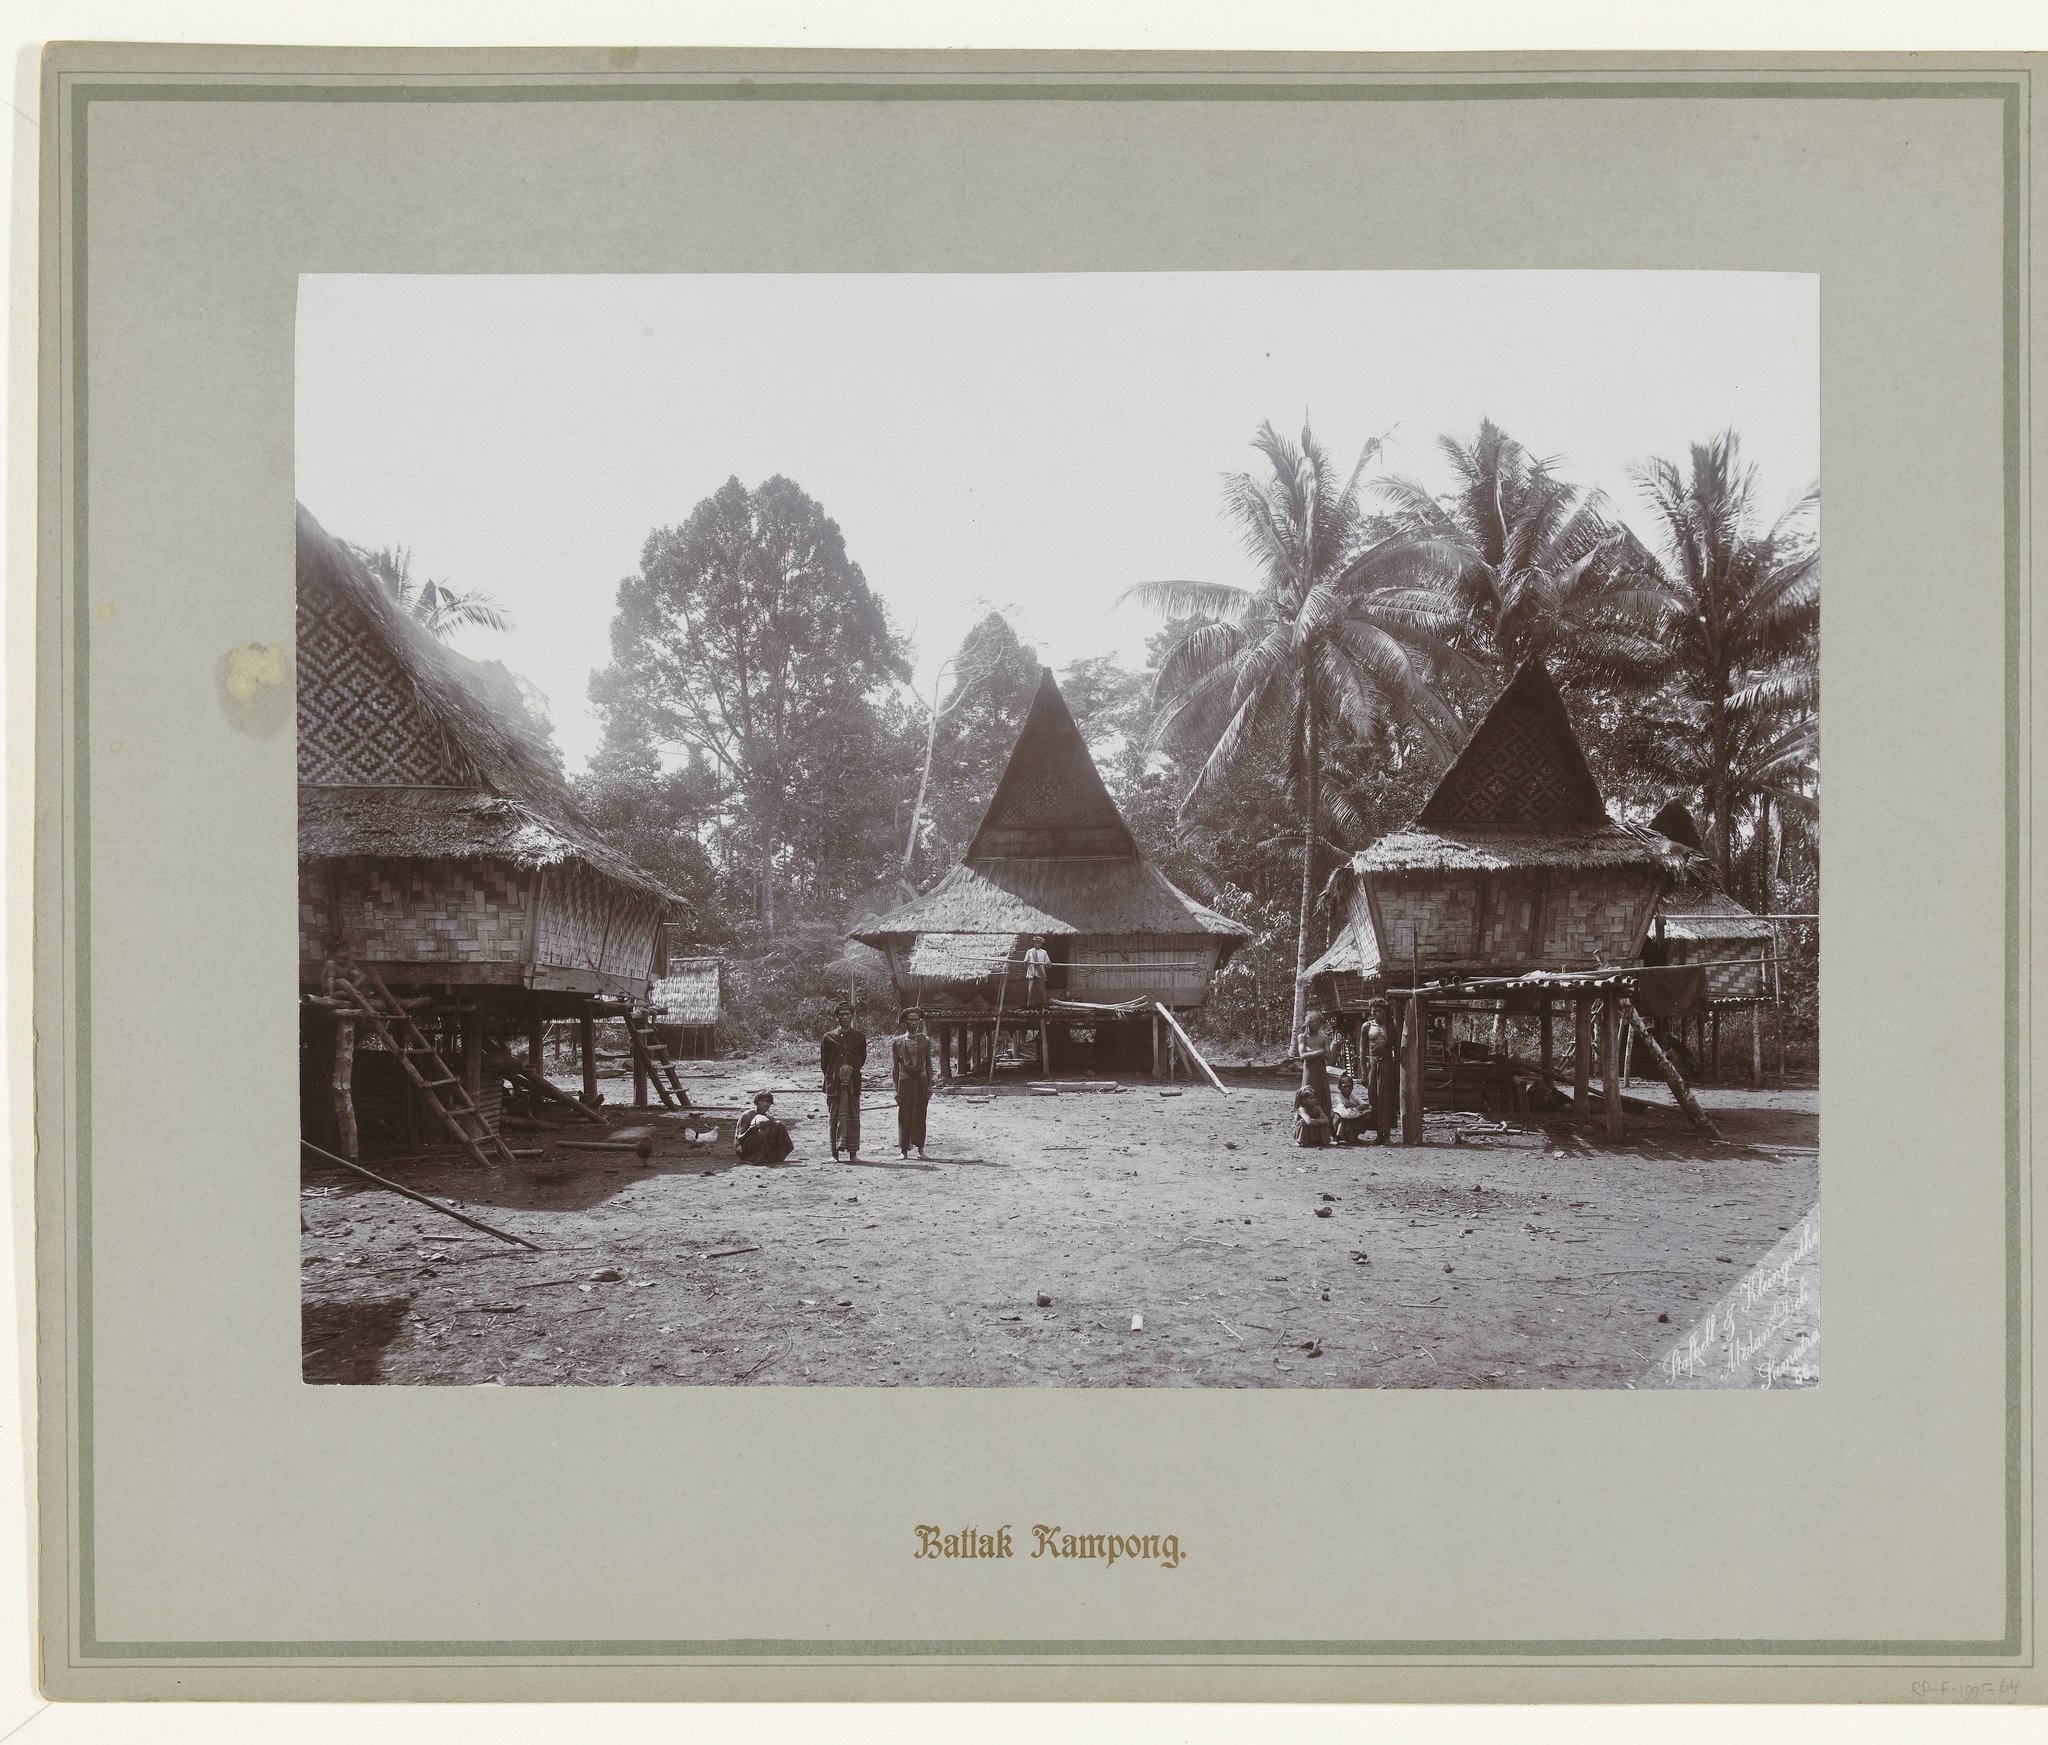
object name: photograph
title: Battak kampong op Sumatra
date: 1890-1910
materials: cardboard, paper, photographic support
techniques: collodion silver print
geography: medan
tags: human races, peoples and nationalities (other than prehistoric or extinct), sumatra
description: Battak kampong op Sumatra. Foto geplakt op blad dat is losgesneden uit een album, op verso bevindt zich nog een foto uit de serie.